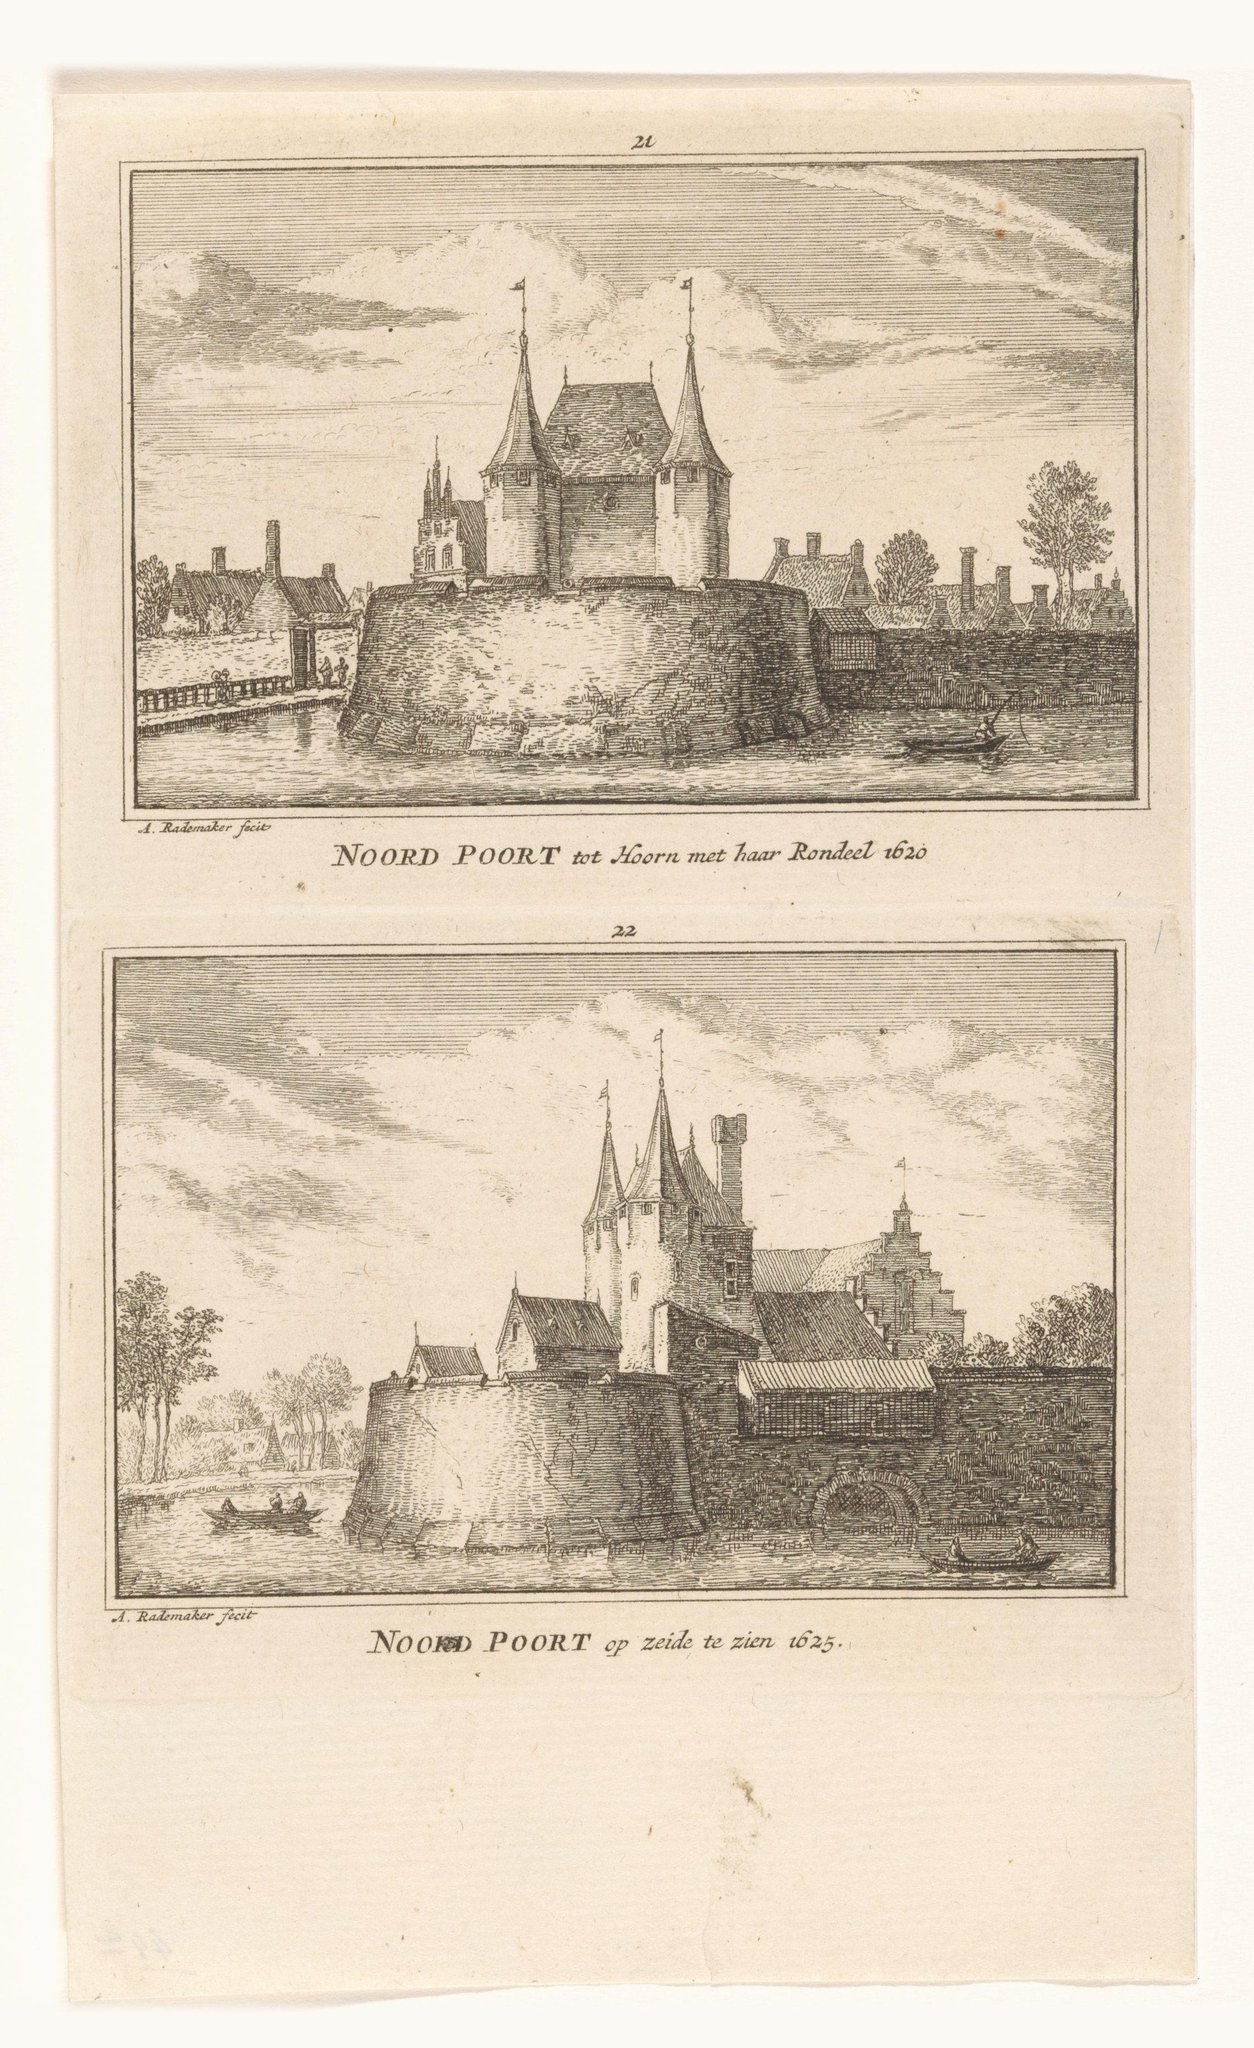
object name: print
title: Noord Poort op zeide te zien 1625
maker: abraham rademaker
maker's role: draughtsman, print maker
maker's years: 1676-1735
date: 1725-1803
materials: paper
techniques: engraving, etching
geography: amsterdam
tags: rowing-boat, canoe, etc., fortifications, military engineering, fortified city, city-gate, fisherman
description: Prent ook gebruikt in: Rademaker, Abraham. Kabinet van Nederlandsche outheden en gezichten: vervat in 300 konstplaaten (…). 2 delen. Amsterdam: Willem Barents, 1725, dl. 1, ill. 21 en 22. Na 1725 is deze prent nog in verschillende heruitgaven verschenen, uitgegeven in 1727-1733, 1770-1771 en 1792-1803. Uit welke uitgave het huidige exemplaar precies komt is niet na te gaan.